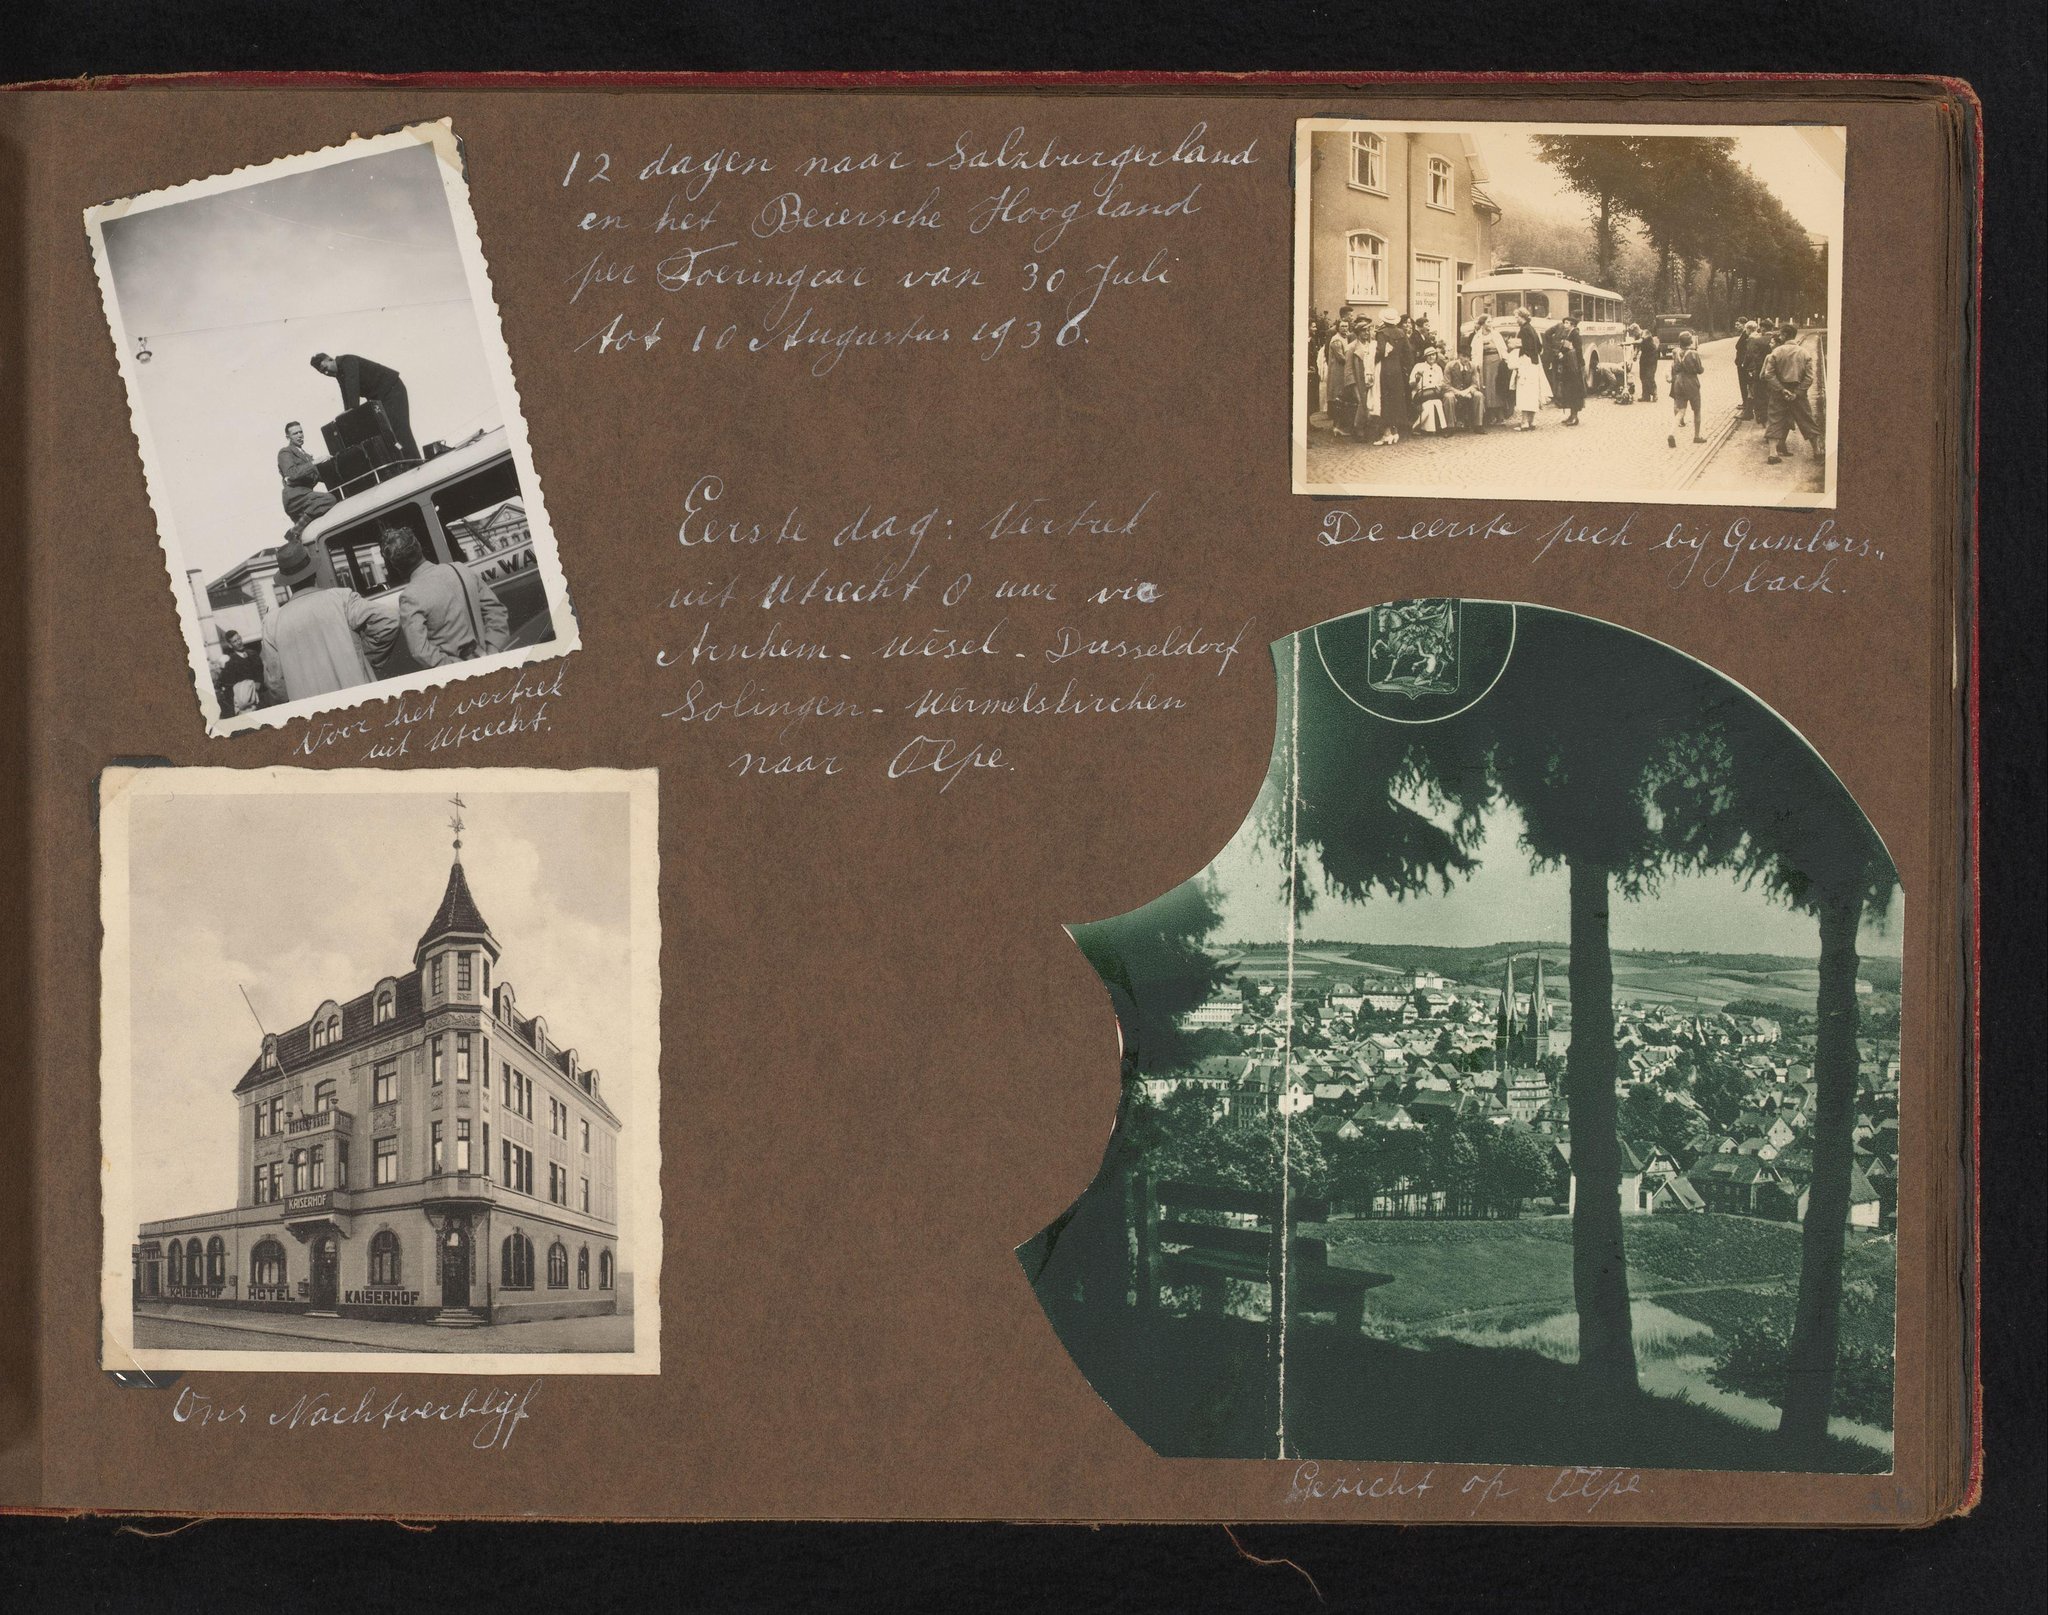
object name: photograph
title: Eerste dag: Vertrek uit Utrecht 8 uur via Arnhem-Wesel-Dusseldorf-Solingen-Wermelskirchen naar Olpe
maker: Anonymous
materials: paper, photographic support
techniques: photograph, gelatin silver print, rotogravure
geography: germany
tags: bus, coach, accident with bus, coach, outing, pleasure trip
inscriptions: inscription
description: Albumblad met twee foto's en twee afbeeldingen van de reis naar Olpe. Verslag van een twaalfdaagse groepsreis per autobus naar Salzburgerland en Beieren van 30 juli tot 10 augustus 1936. Onderdeel van het reisalbum van de familie Van den Broek 1935-1937.